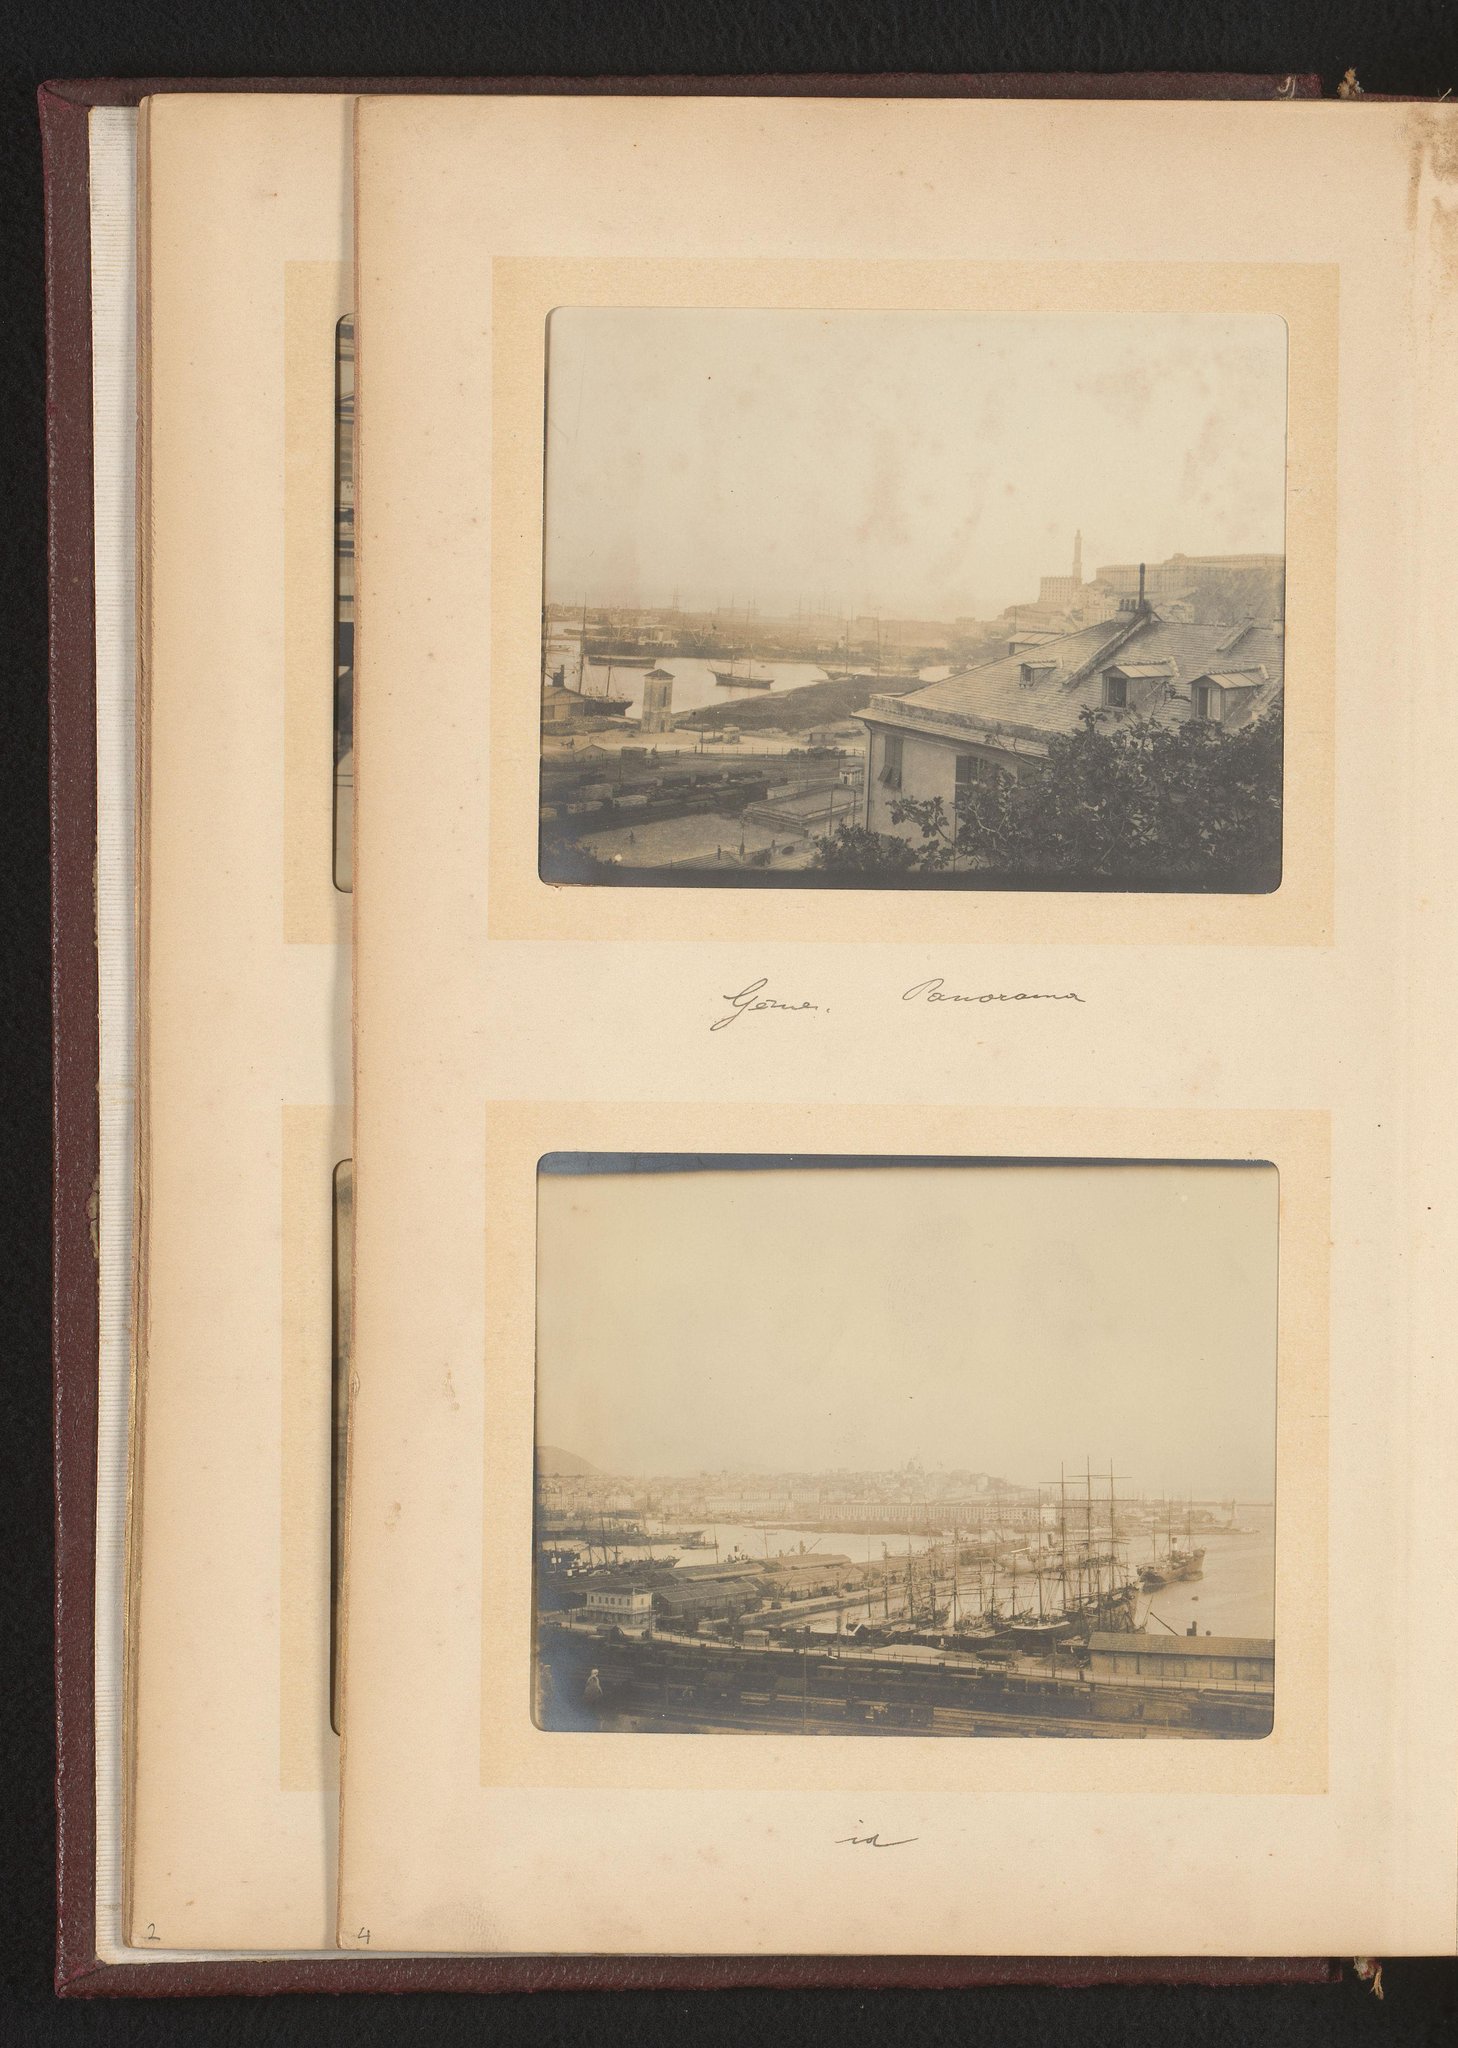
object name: photograph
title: Twee panorama's in Genua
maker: Anonymous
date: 1895-1905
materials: cardboard, photographic support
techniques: gelatin silver print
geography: genoa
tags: tourism, city-view in general; 'veduta' (+ city(-scape) with figures, staffage)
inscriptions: inscription: ‘Genes Panorma/ id.’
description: Albumblad met twee foto's van Genua. Onderdeel van een fotoalbum van een reis door Italië, ca. 1900.